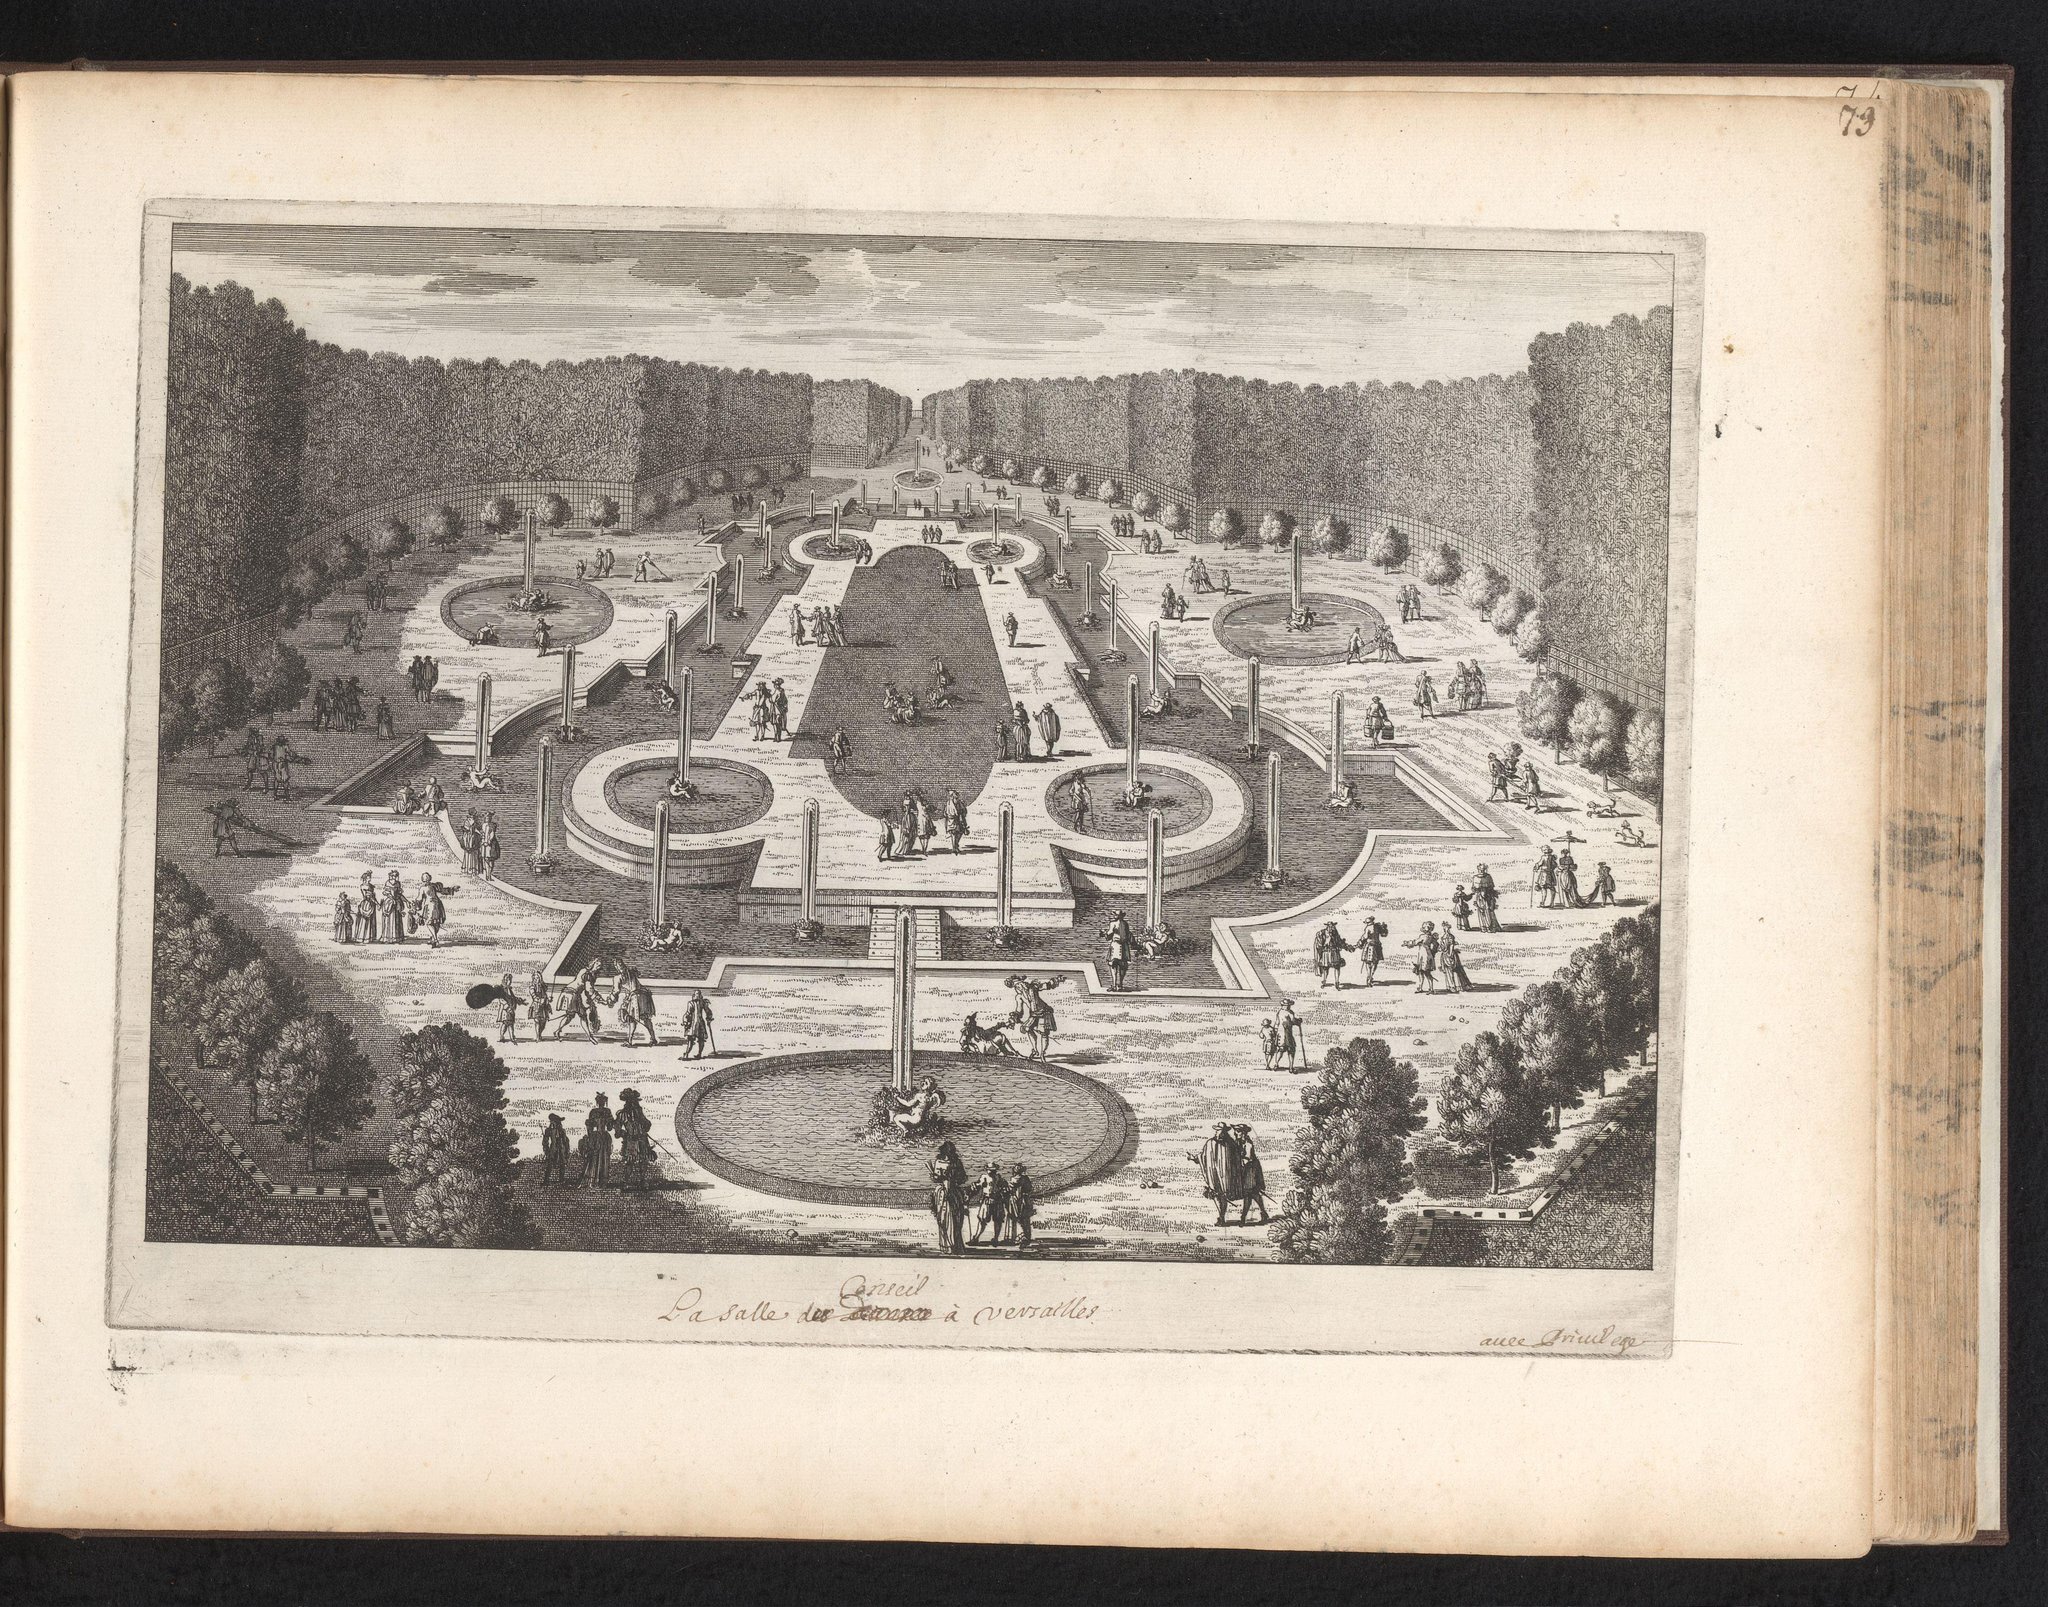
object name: album leaf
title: La Salle de Conseil à Versailles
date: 1672-1703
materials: paper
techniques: etching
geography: paris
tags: garden fountain, french or architectonic garden; formal garden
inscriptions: collector's mark: Lugt 2228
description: Prenten met het signatuur 'Perelle' kunnen zowel door vader Gabriel als door zonen Nicolas en Adam gemaakt zijn. De uitgevers vader en zoon Nicolas Langlois worden allebei vermeld als N. Langlois op hetzelfde adres.